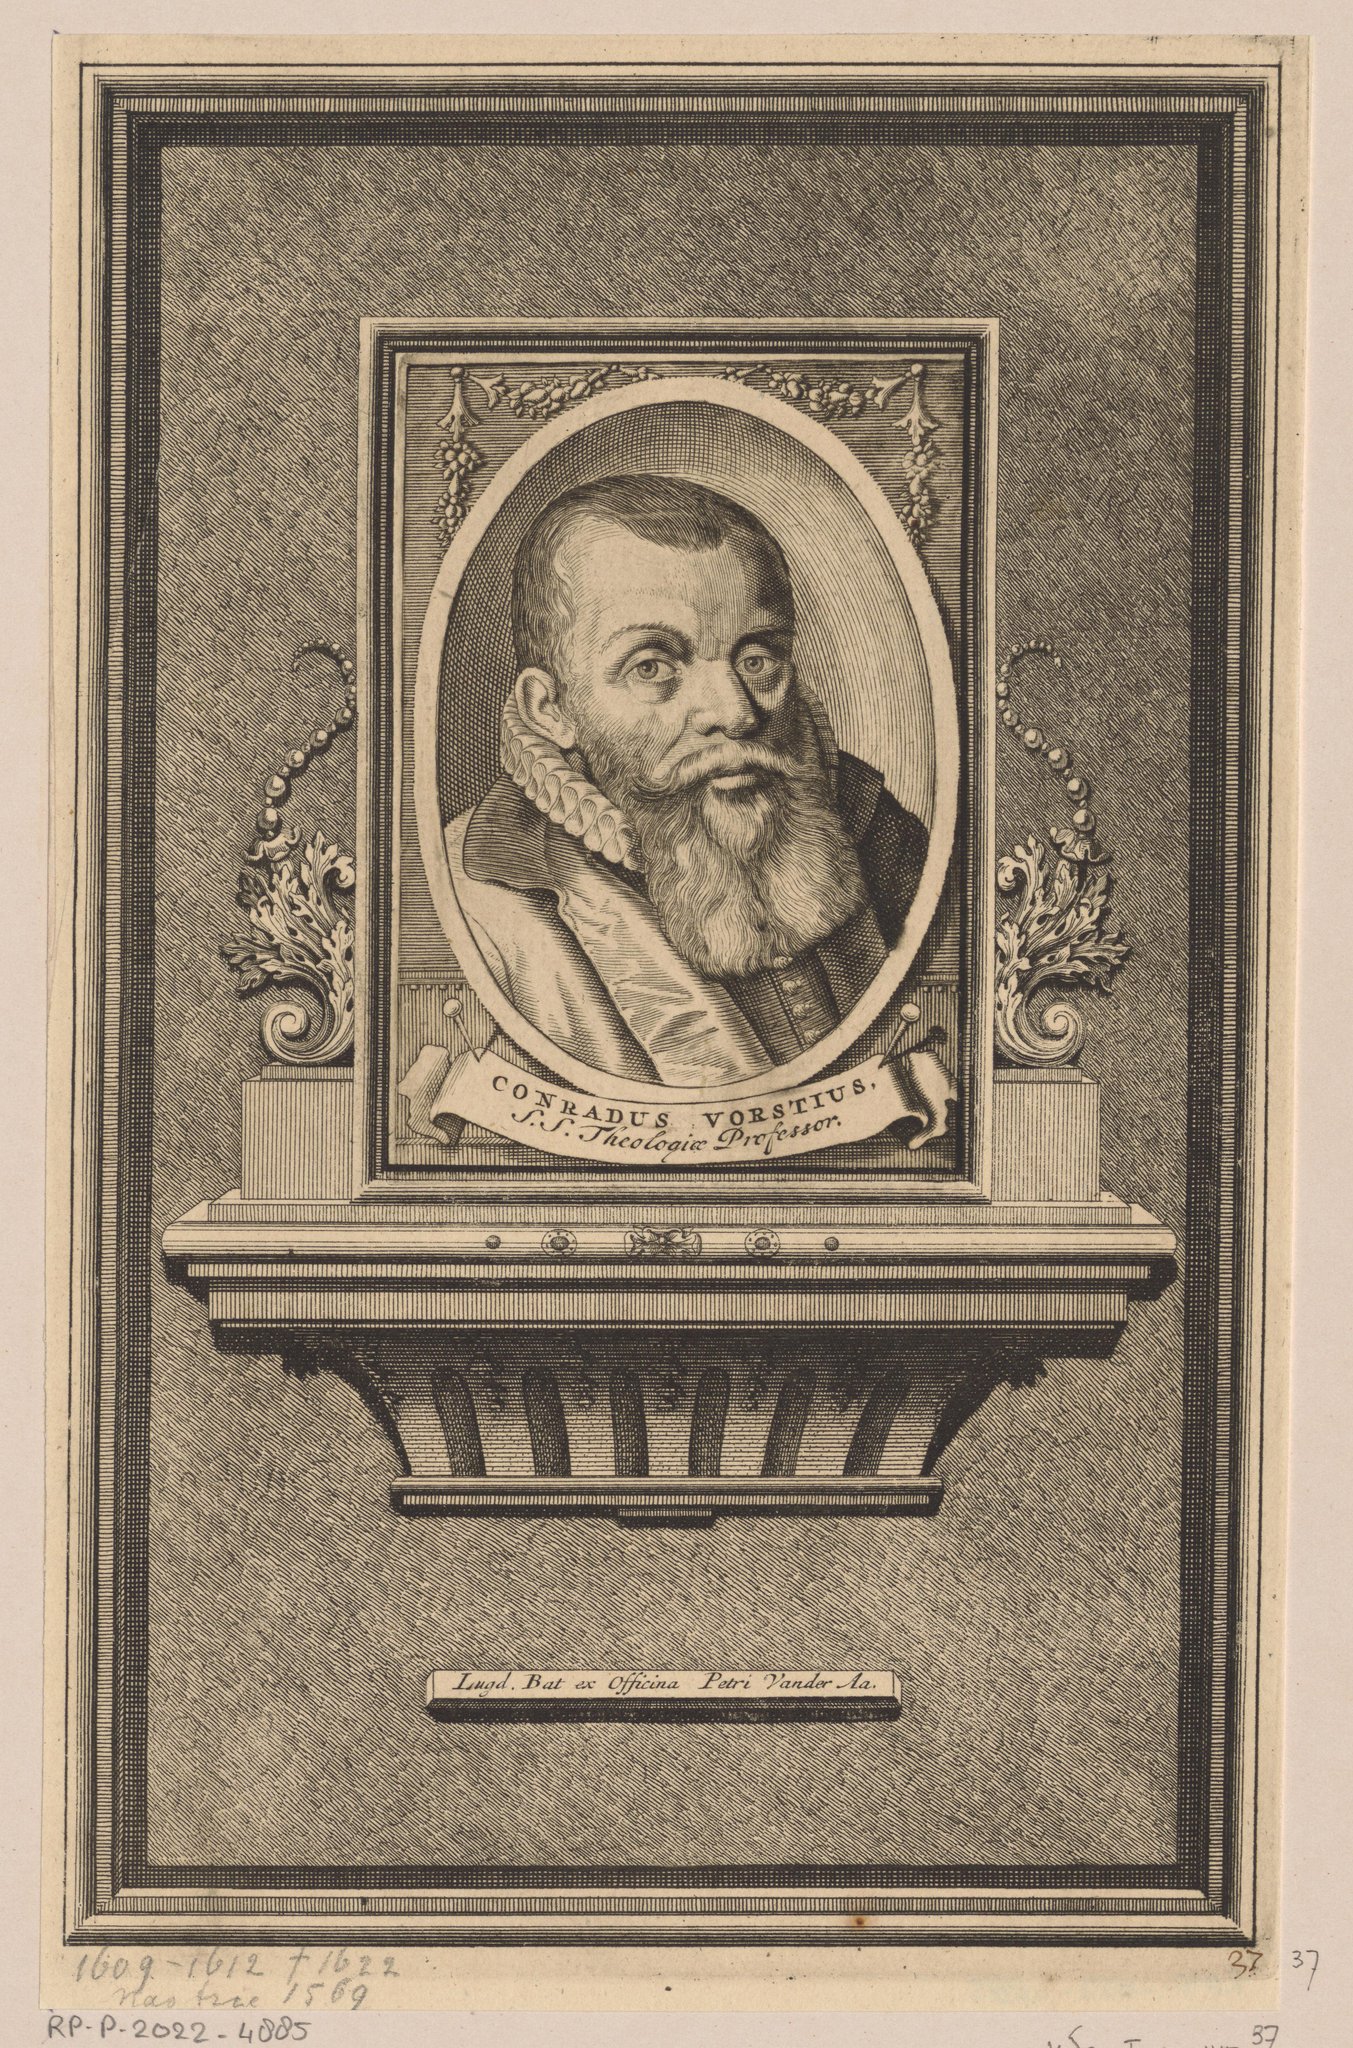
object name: print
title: Beroemde mannen aan de universiteit van Leiden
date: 1716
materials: paper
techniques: engraving, etching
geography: leiden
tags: scholar, philosopher, historical persons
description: Met omlijsting gedrukt van een aparte plaat, rechtsonder handgeschreven genummerd: 37.